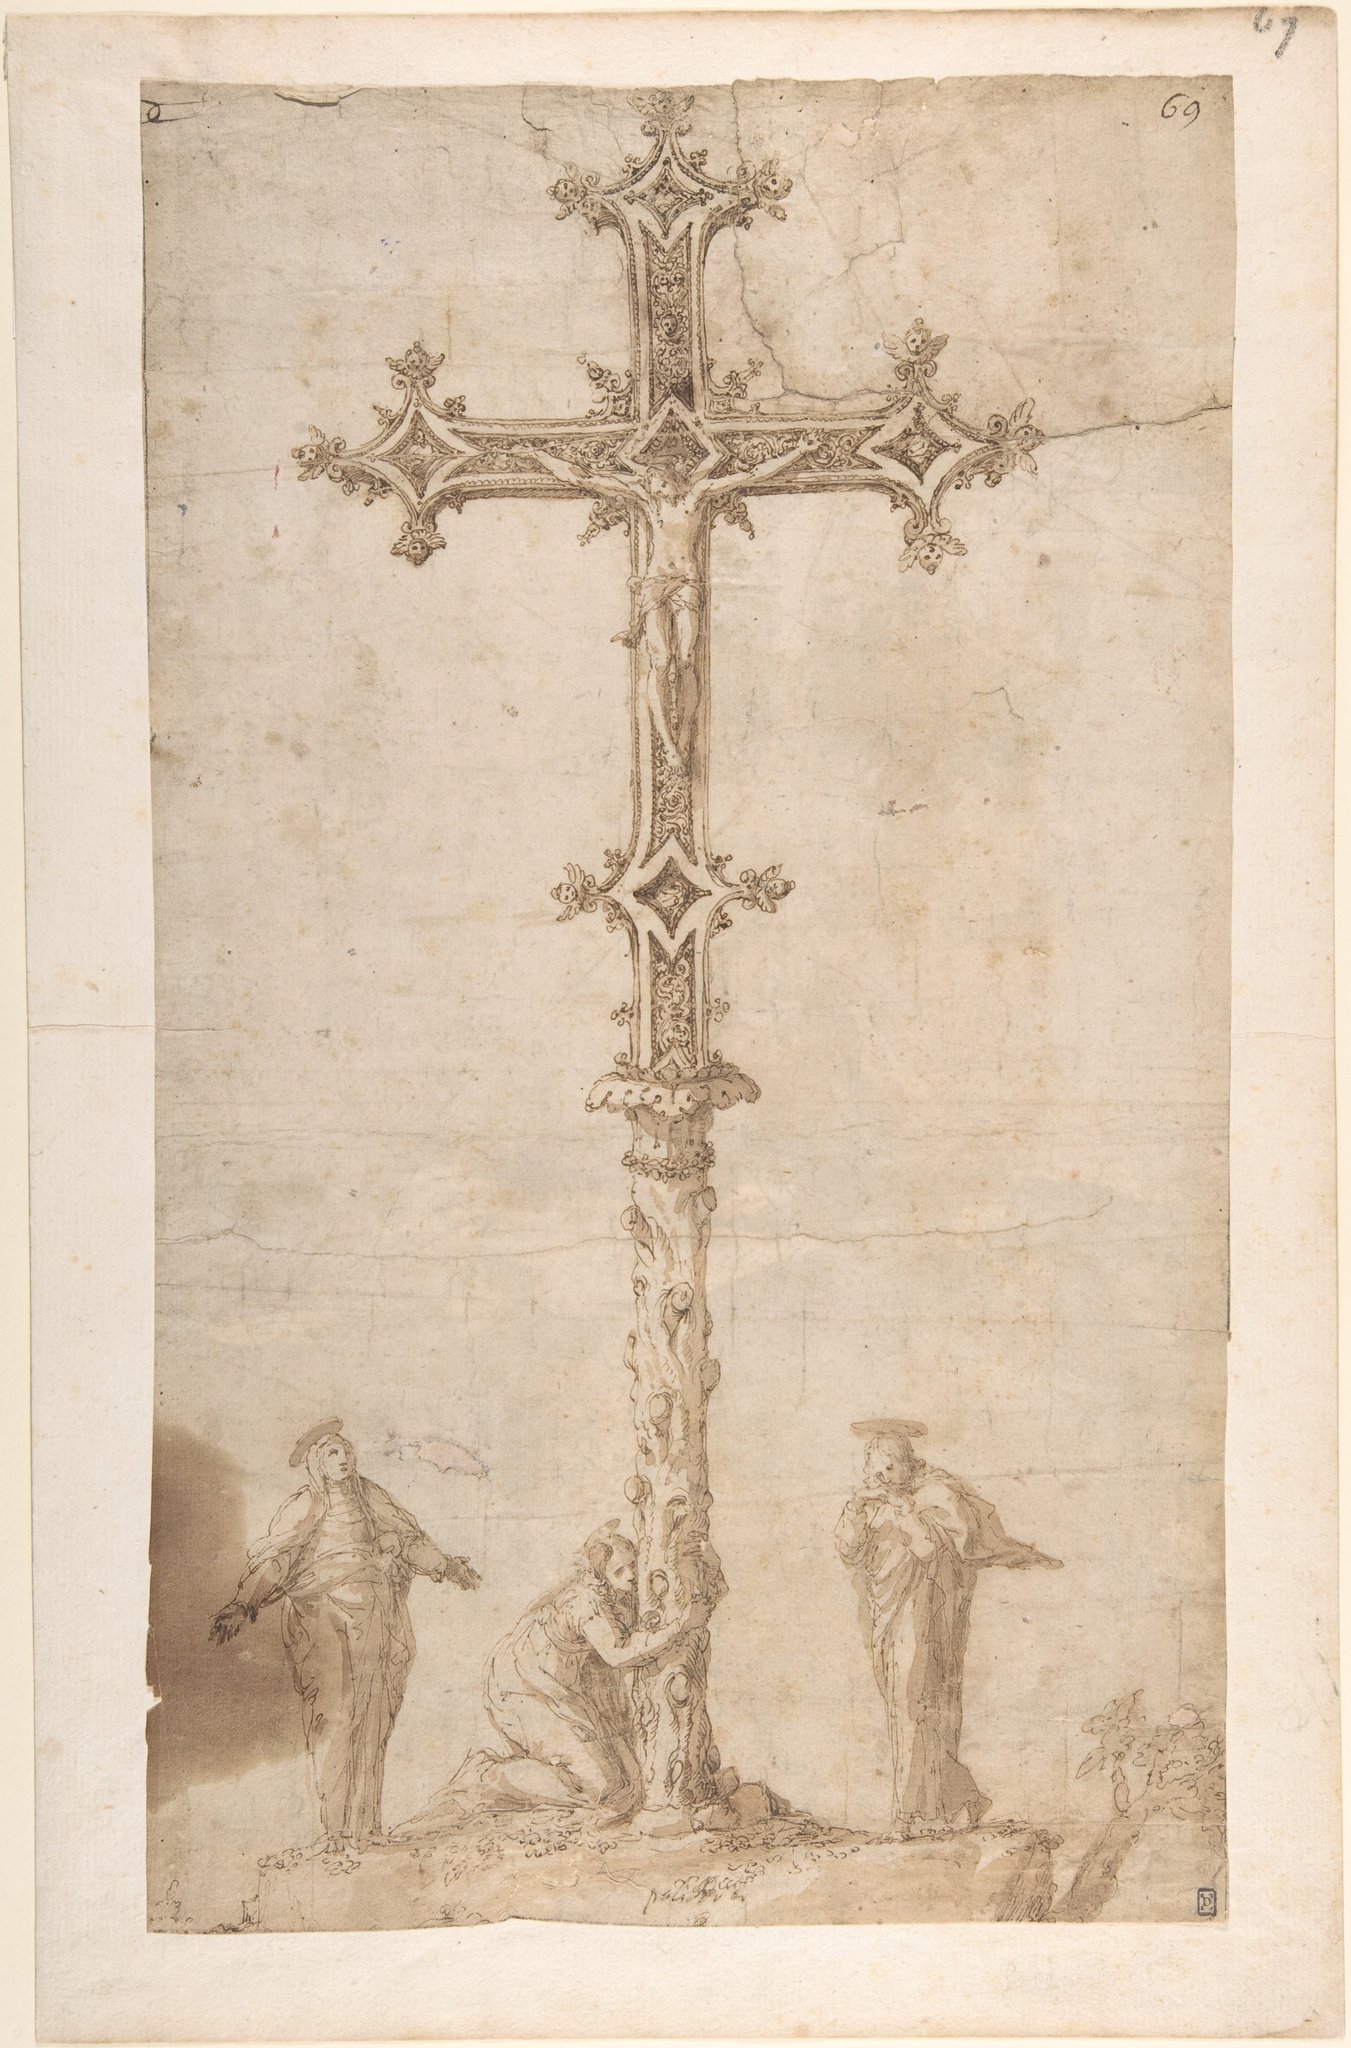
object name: drawing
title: Design for a Crucifix with the Virgin Mary, Saint Mary Magdalen, and Saint John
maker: polidoro da caravaggio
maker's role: artist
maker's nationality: italian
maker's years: 1494-1548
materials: chalk, ink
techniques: brush, pen, wash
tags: mary magdalene,saint john the baptist,virgin mary,jesus,crucifixion